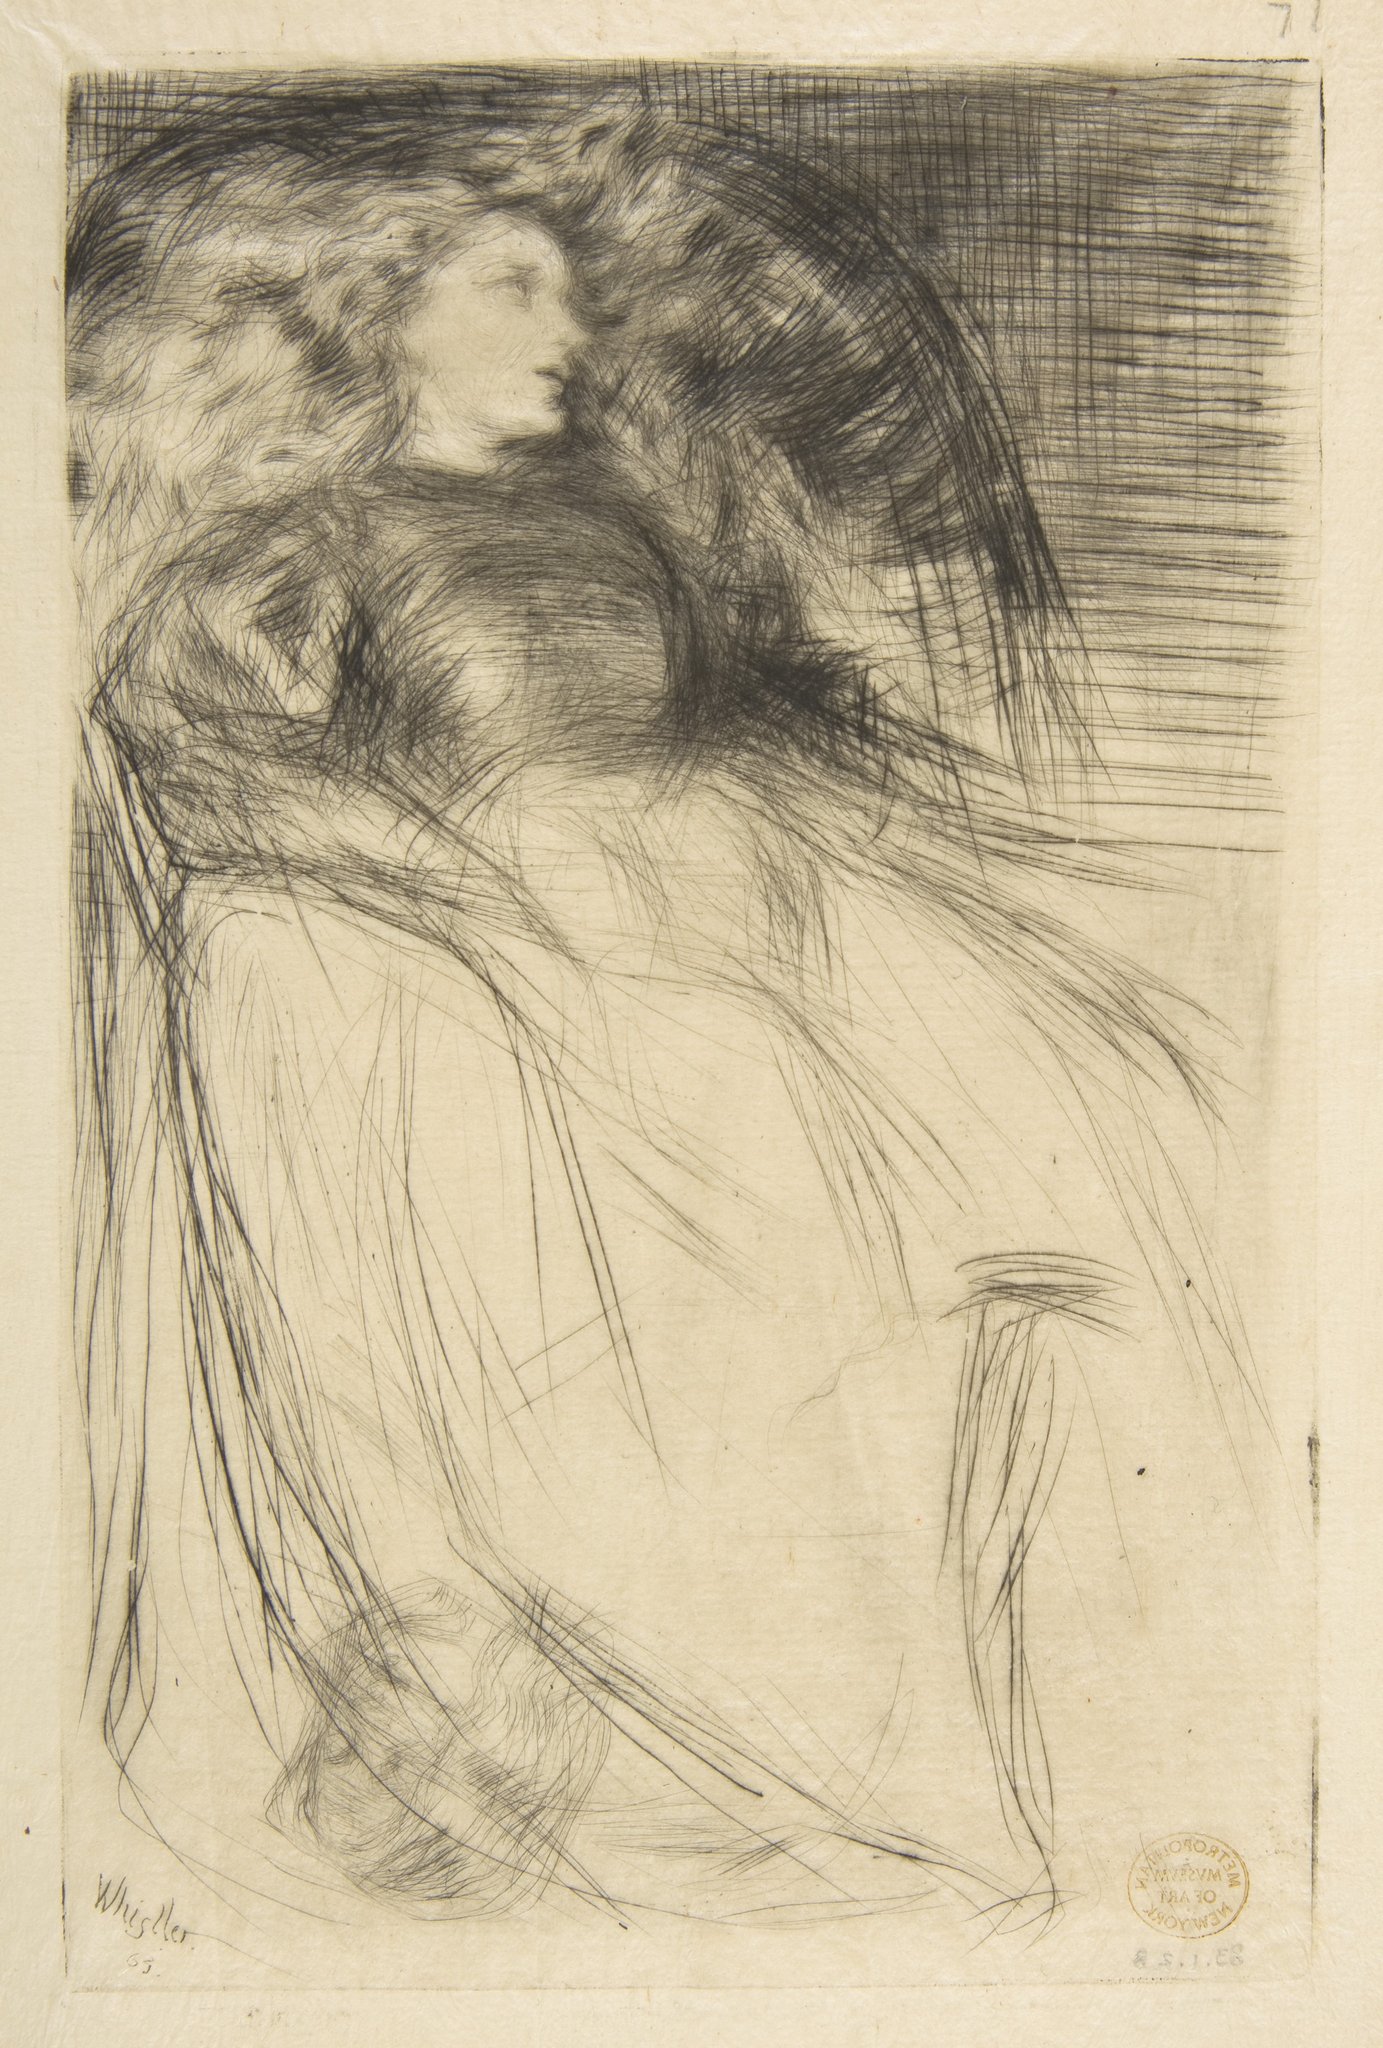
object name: print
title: Weary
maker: james mcneill whistler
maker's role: artist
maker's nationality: american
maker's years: 1834-1903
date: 1863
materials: ink, ivory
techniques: drypoint, printing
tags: women